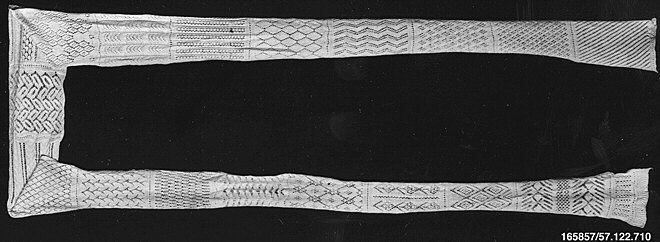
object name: sampler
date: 1801-1900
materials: lace, wool